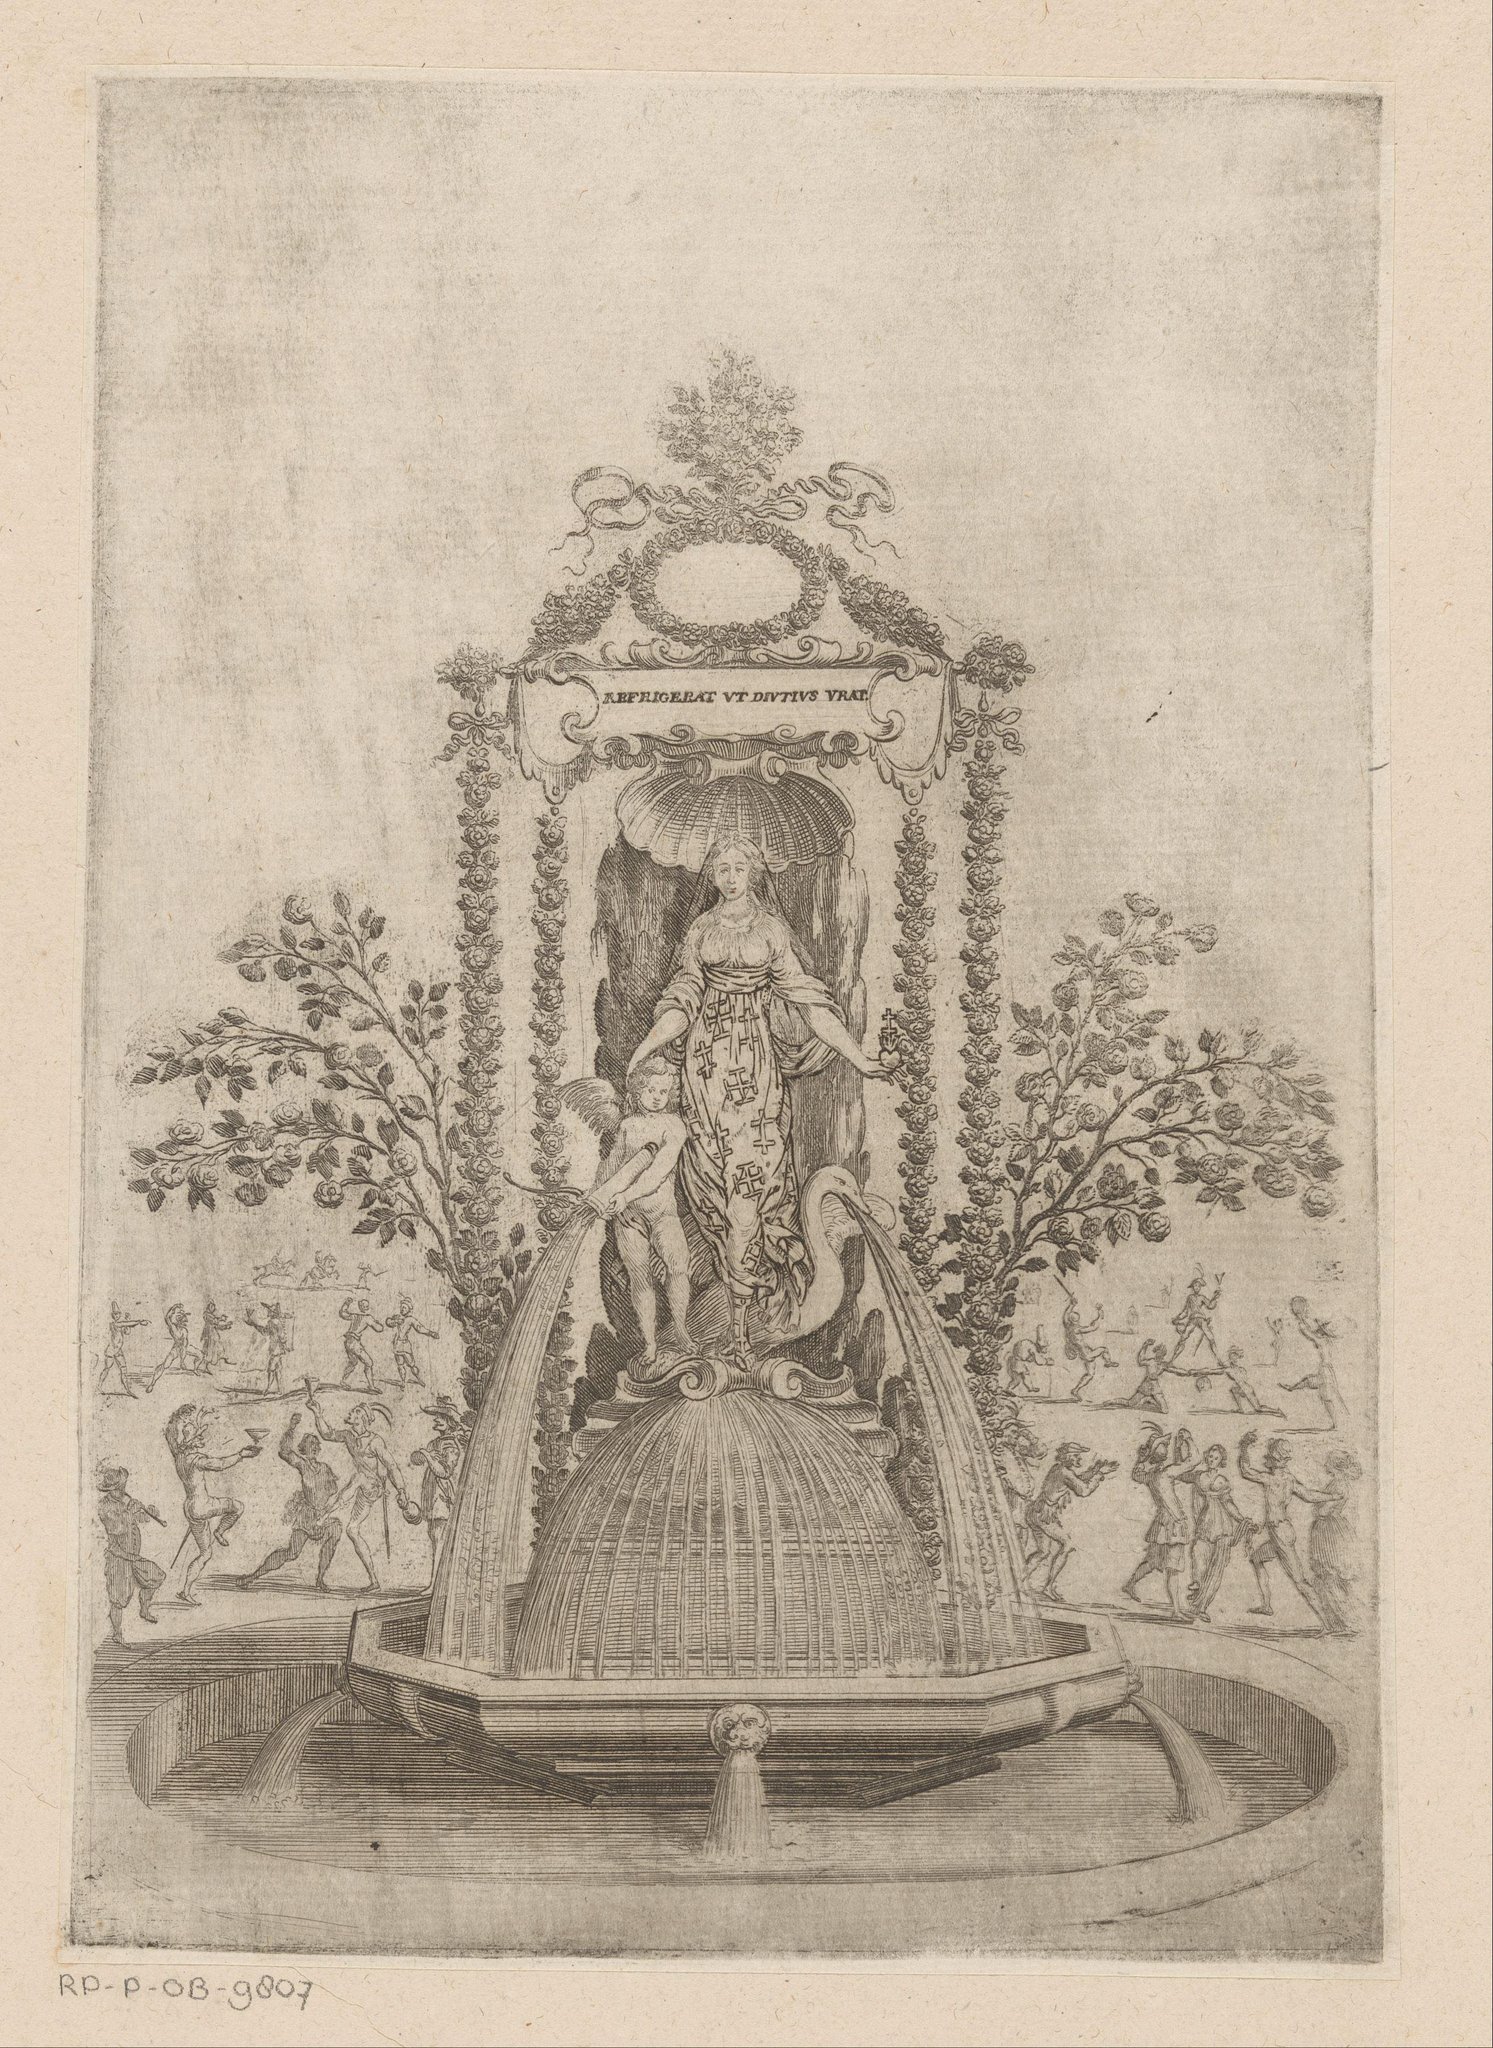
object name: print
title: Fontein met vrouw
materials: paper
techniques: etching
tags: standing figure - aa - female human figure, ornamental fountain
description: Een fontein met een staande vrouw met kruizen op haar kleding. Links van haar staat een putto met boog pijlenkoker waar water uit stroom. Rechts staat een zwaan met open bek waar water uit stroom. Boven de vrouw een schelpmotief en een krans.